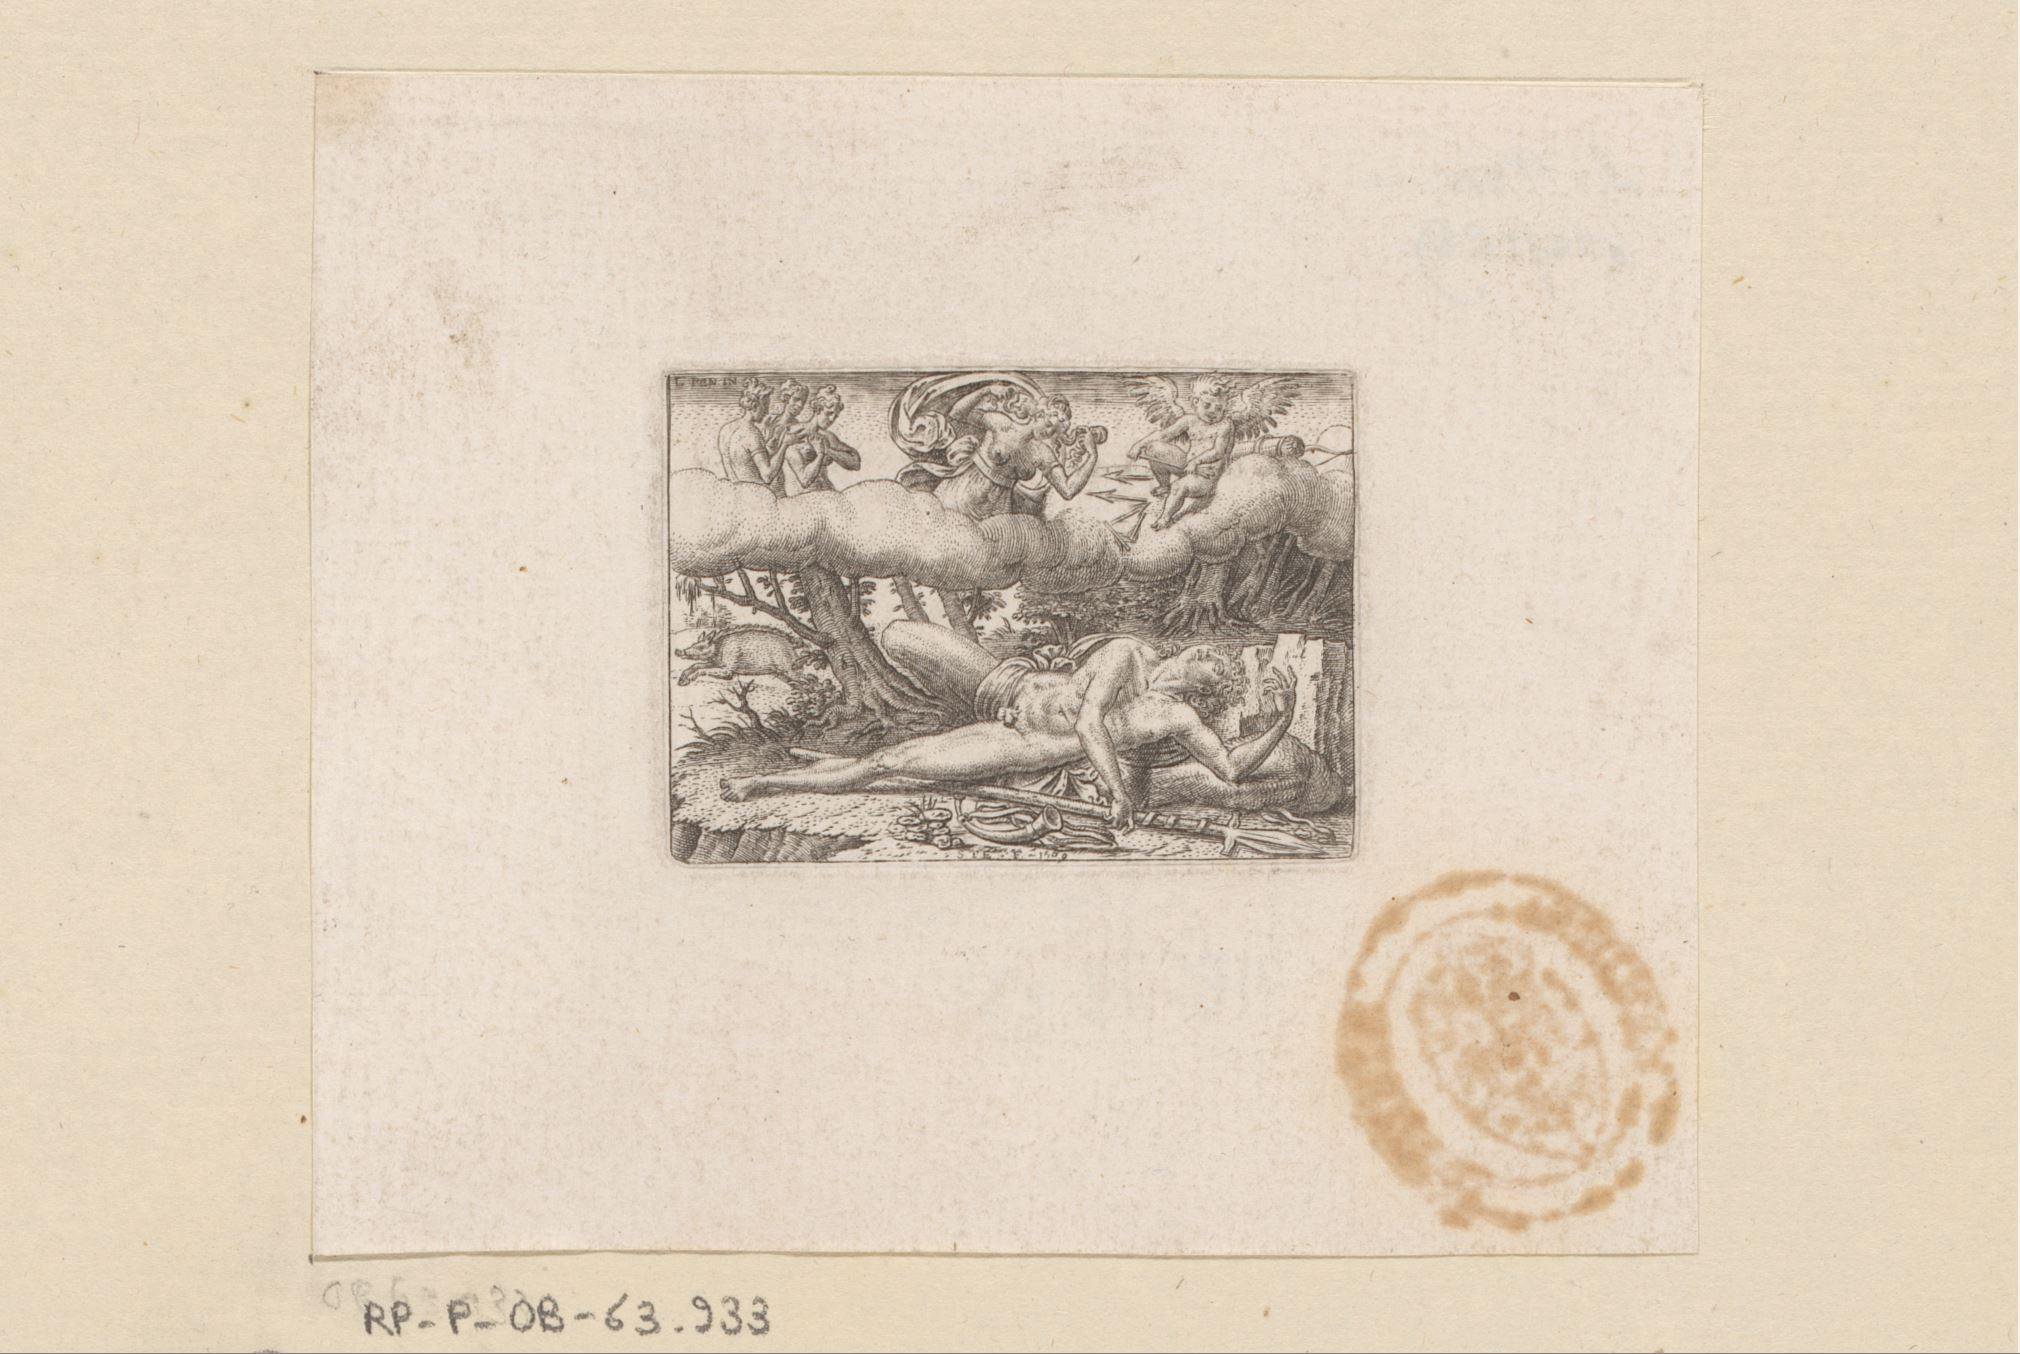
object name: print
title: Venus, de Gratiën en Amor betreuren de dood van Adonis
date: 1569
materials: paper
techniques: engraving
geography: france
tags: death of adonis: he is killed by a boar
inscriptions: collector's mark: Lugt 240